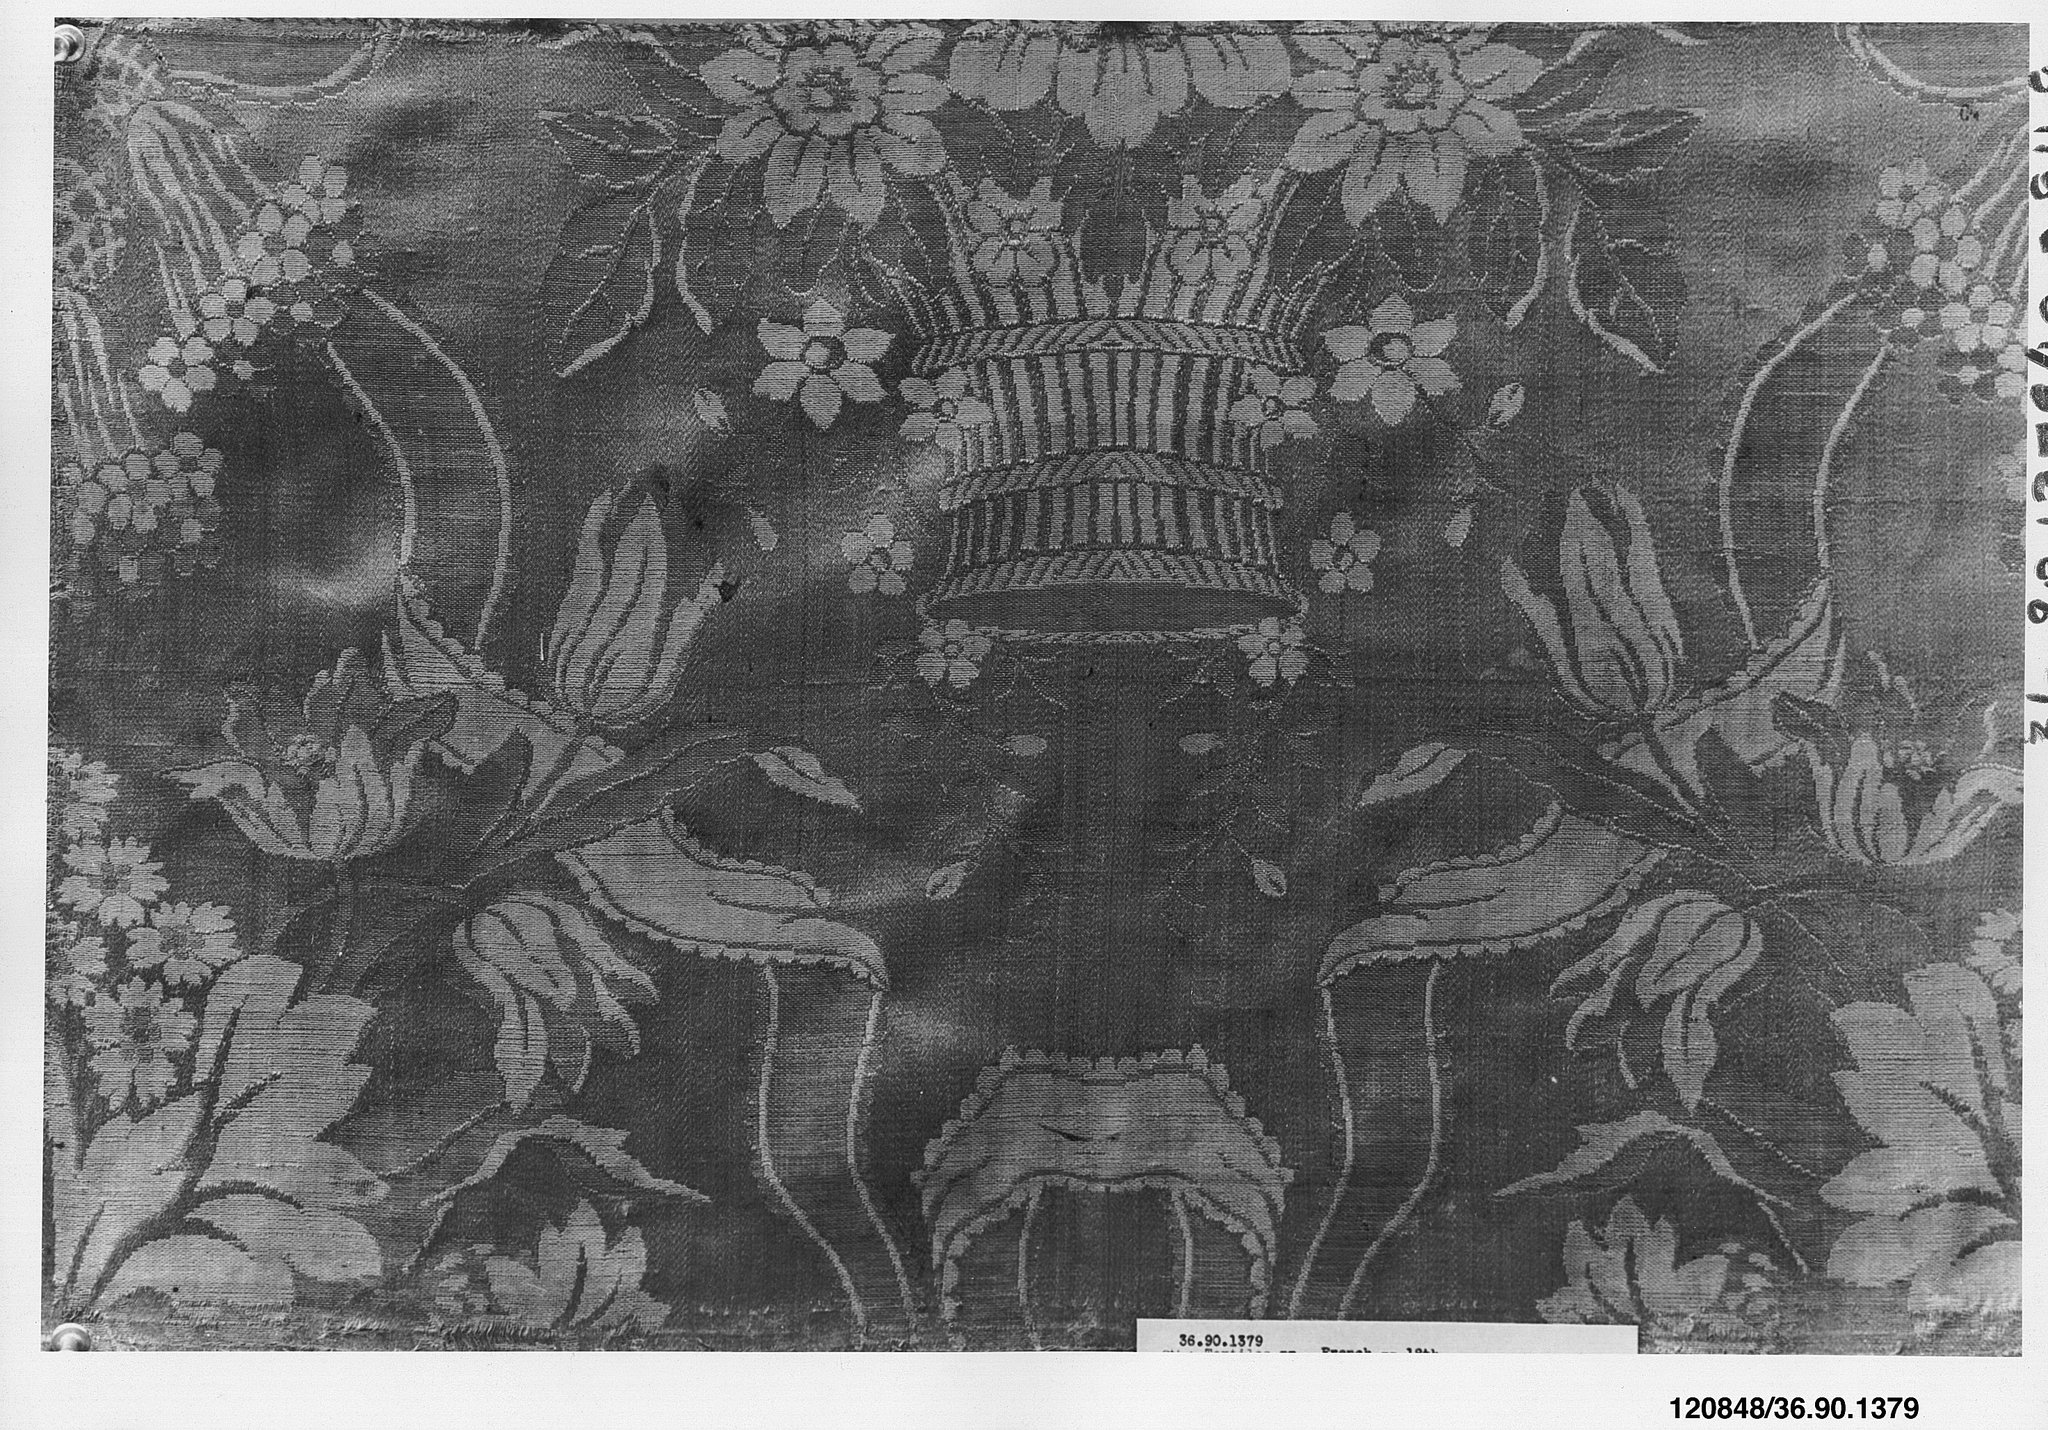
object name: piece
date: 1701-1800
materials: silk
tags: flowers,leaves